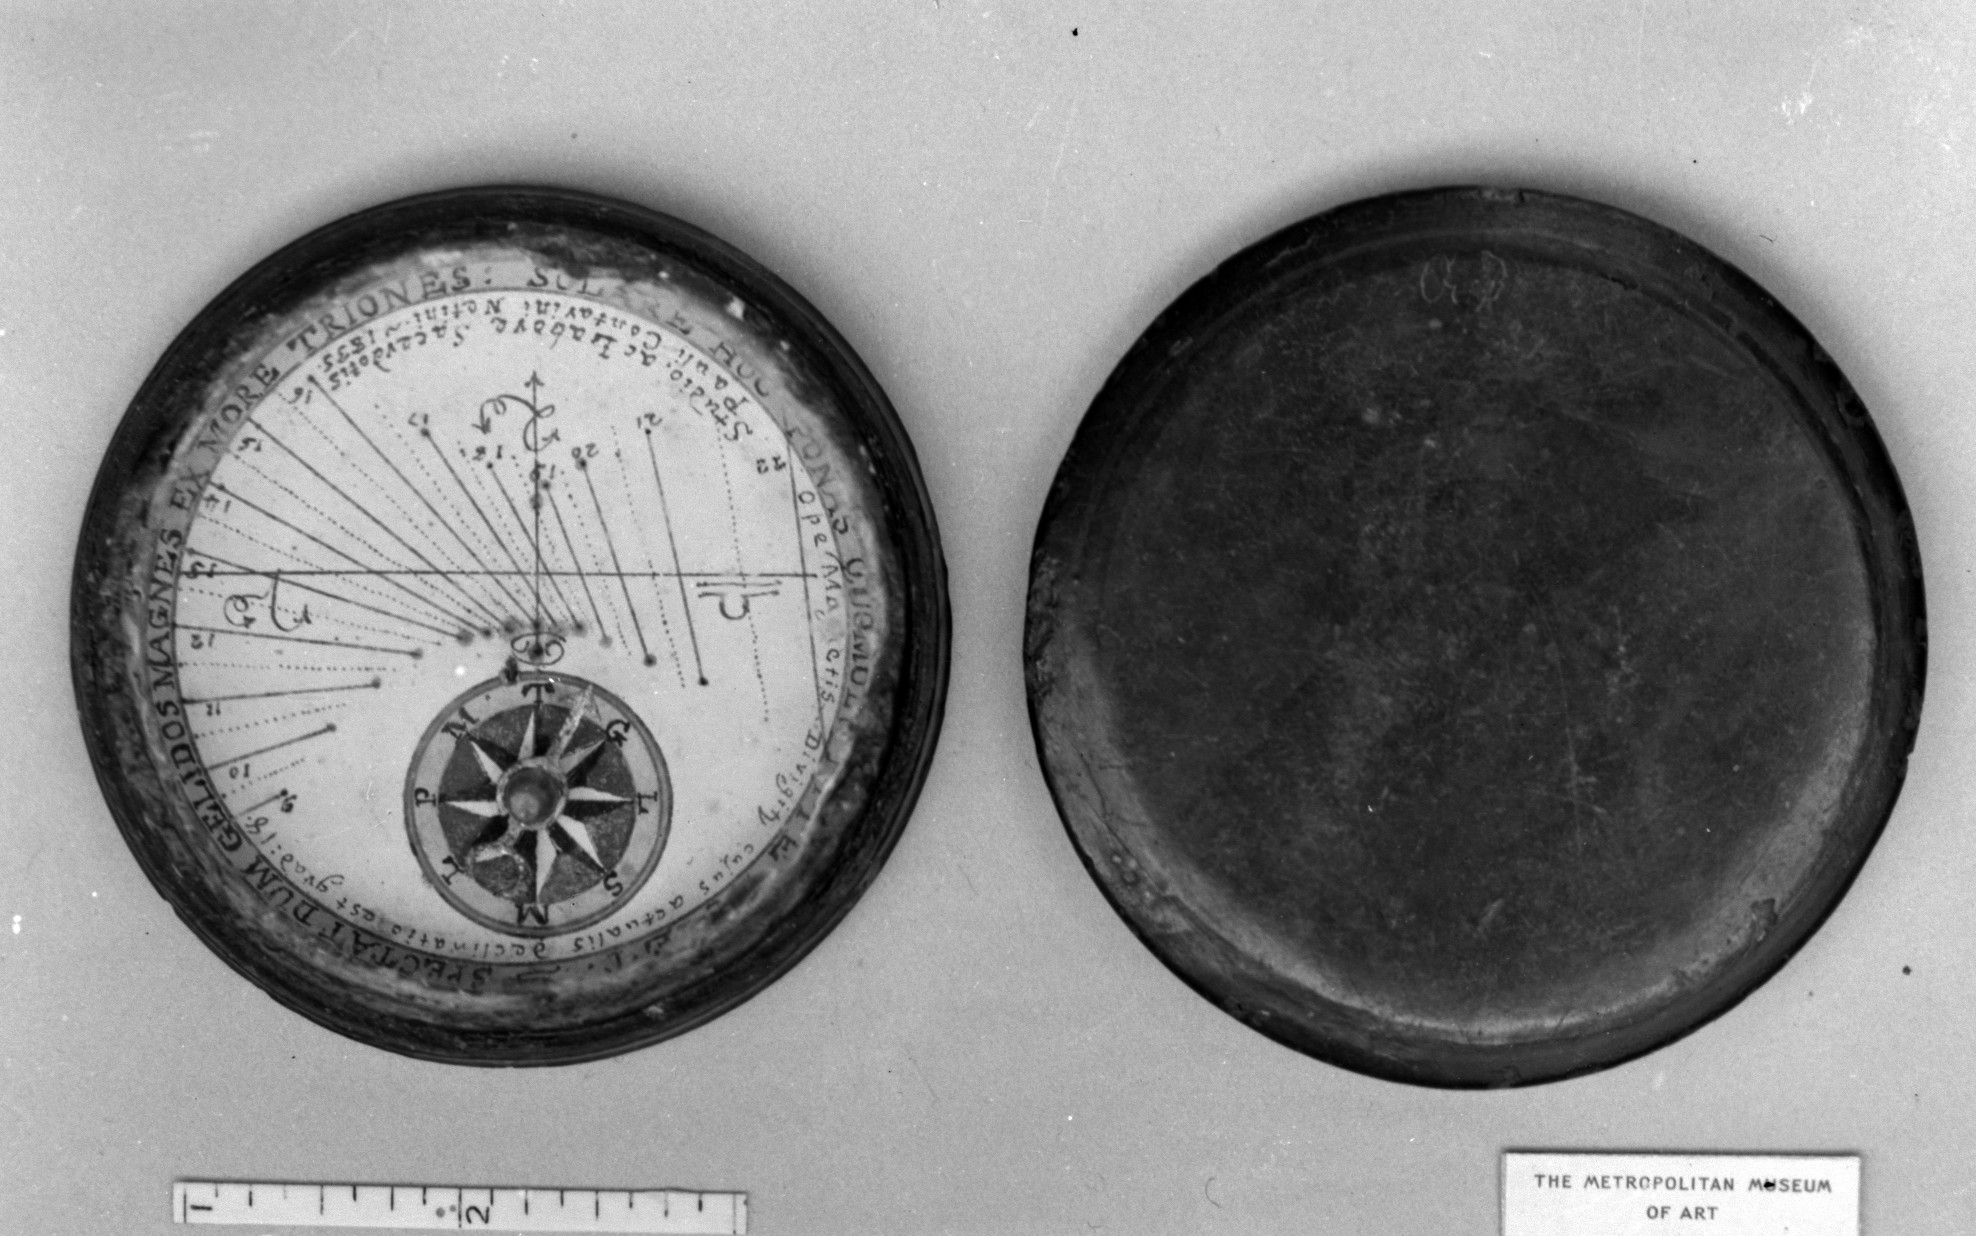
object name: portable compass dial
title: Compass dial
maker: paulo contarini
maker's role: maker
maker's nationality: italian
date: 1835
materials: ink, metal, paint, paper, wood